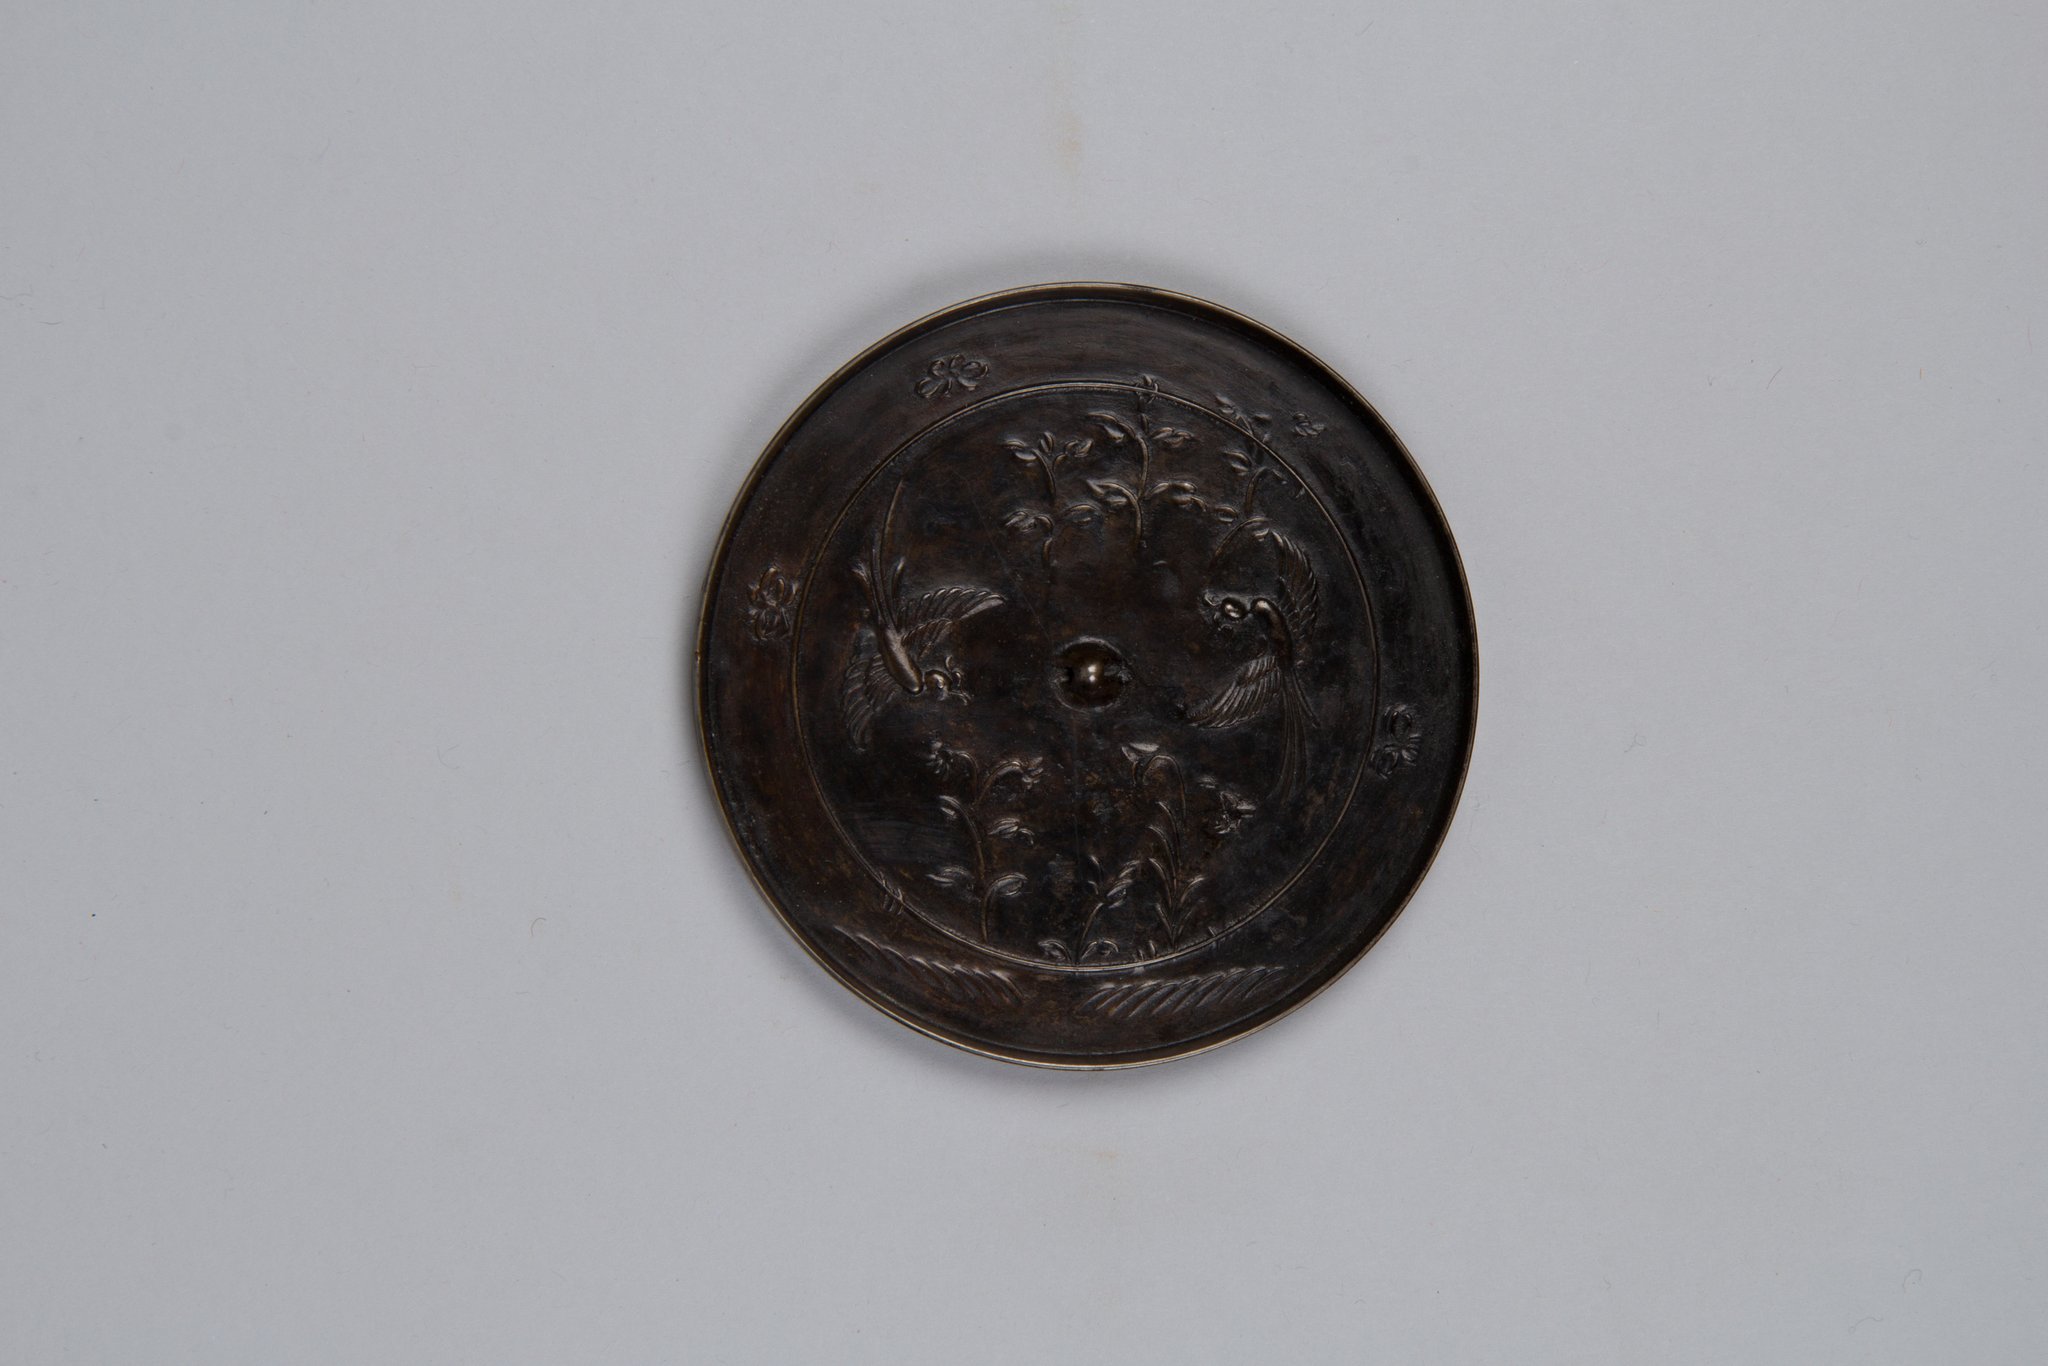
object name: mirror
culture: japanese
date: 900-1185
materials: bronze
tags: birds